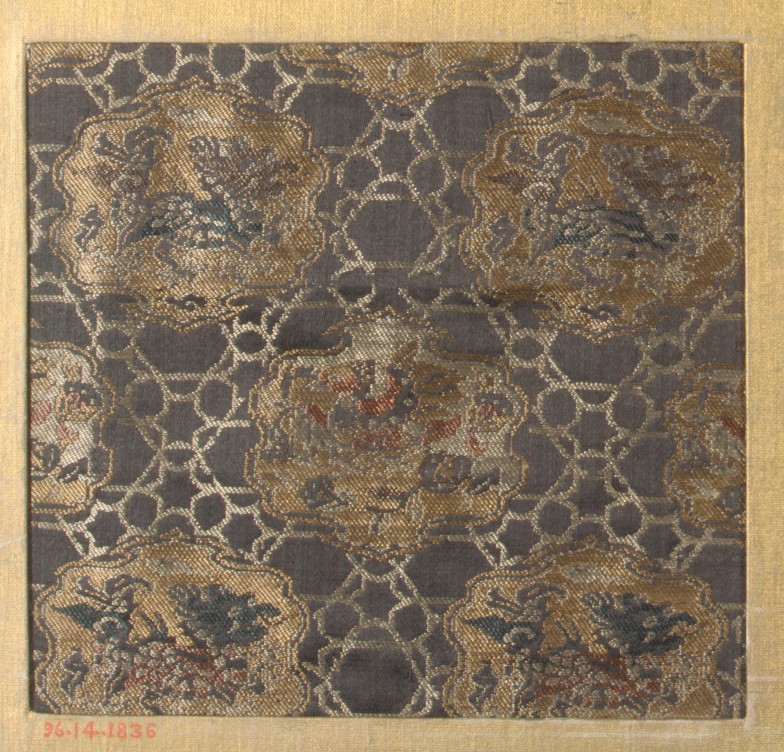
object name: piece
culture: japanese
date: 1701-1900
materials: silk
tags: mythical creatures